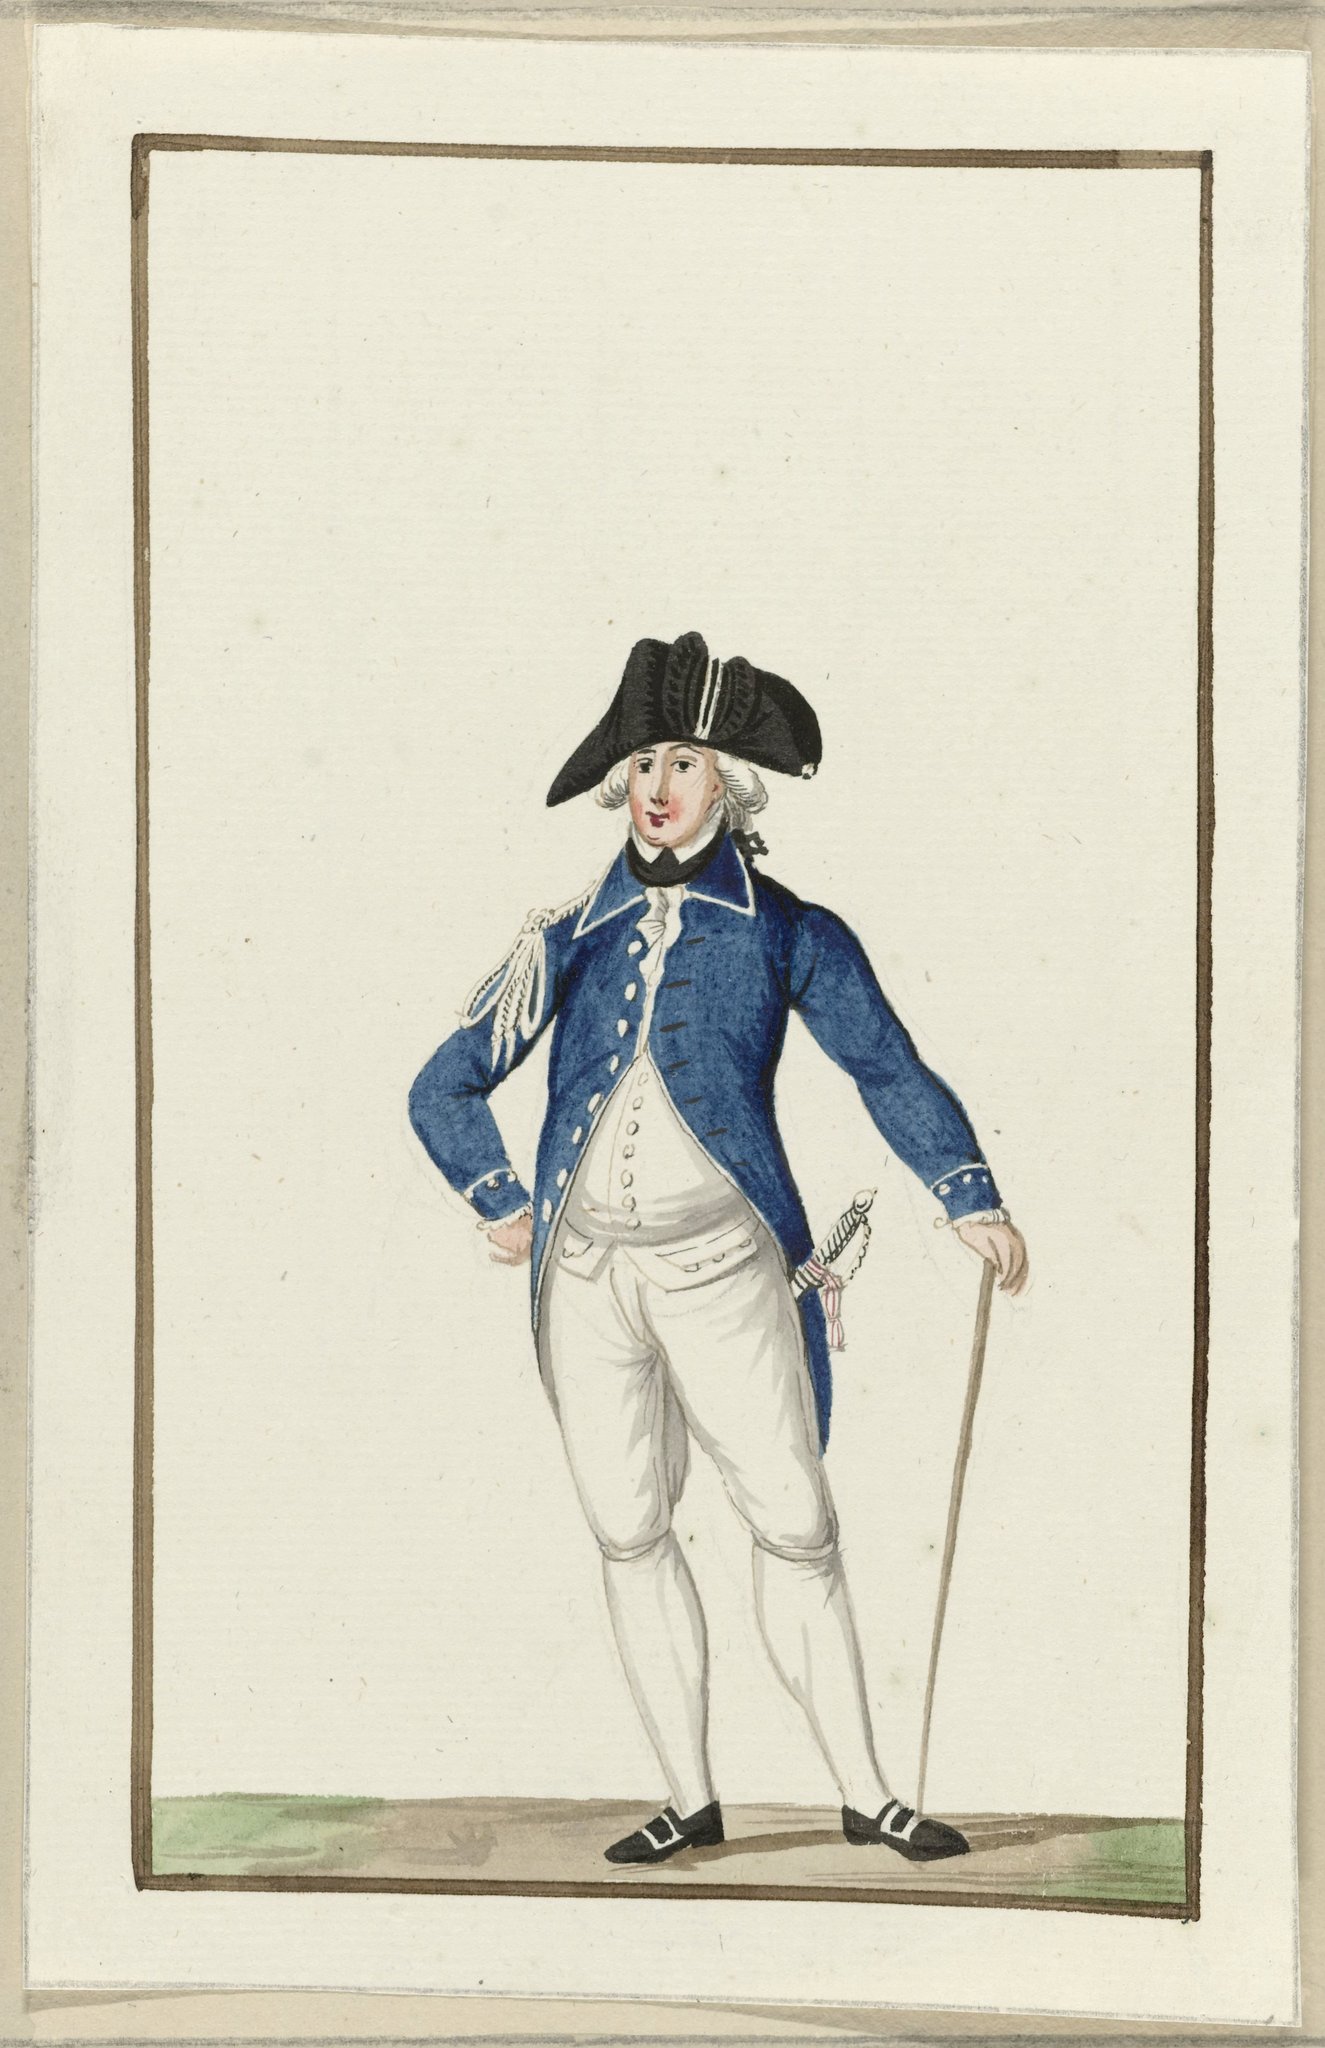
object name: drawing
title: Montering van de schutterij van Leiden, ca. 1787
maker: Anonymous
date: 1787-1790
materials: paper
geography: northern netherlands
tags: (military) uniforms (+ citizen soldiery, civil guard, citizen militia), leiden, patriots (1780-1795)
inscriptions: collector's mark: Lugt 2228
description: Uniform van de schutterij van Leiden. Onderdeel van een serie van 32 tekeningen van de verschillende monteringen (uniformen) van patriotse schutterijen en burgerkorpsen in Nederland in 1787.